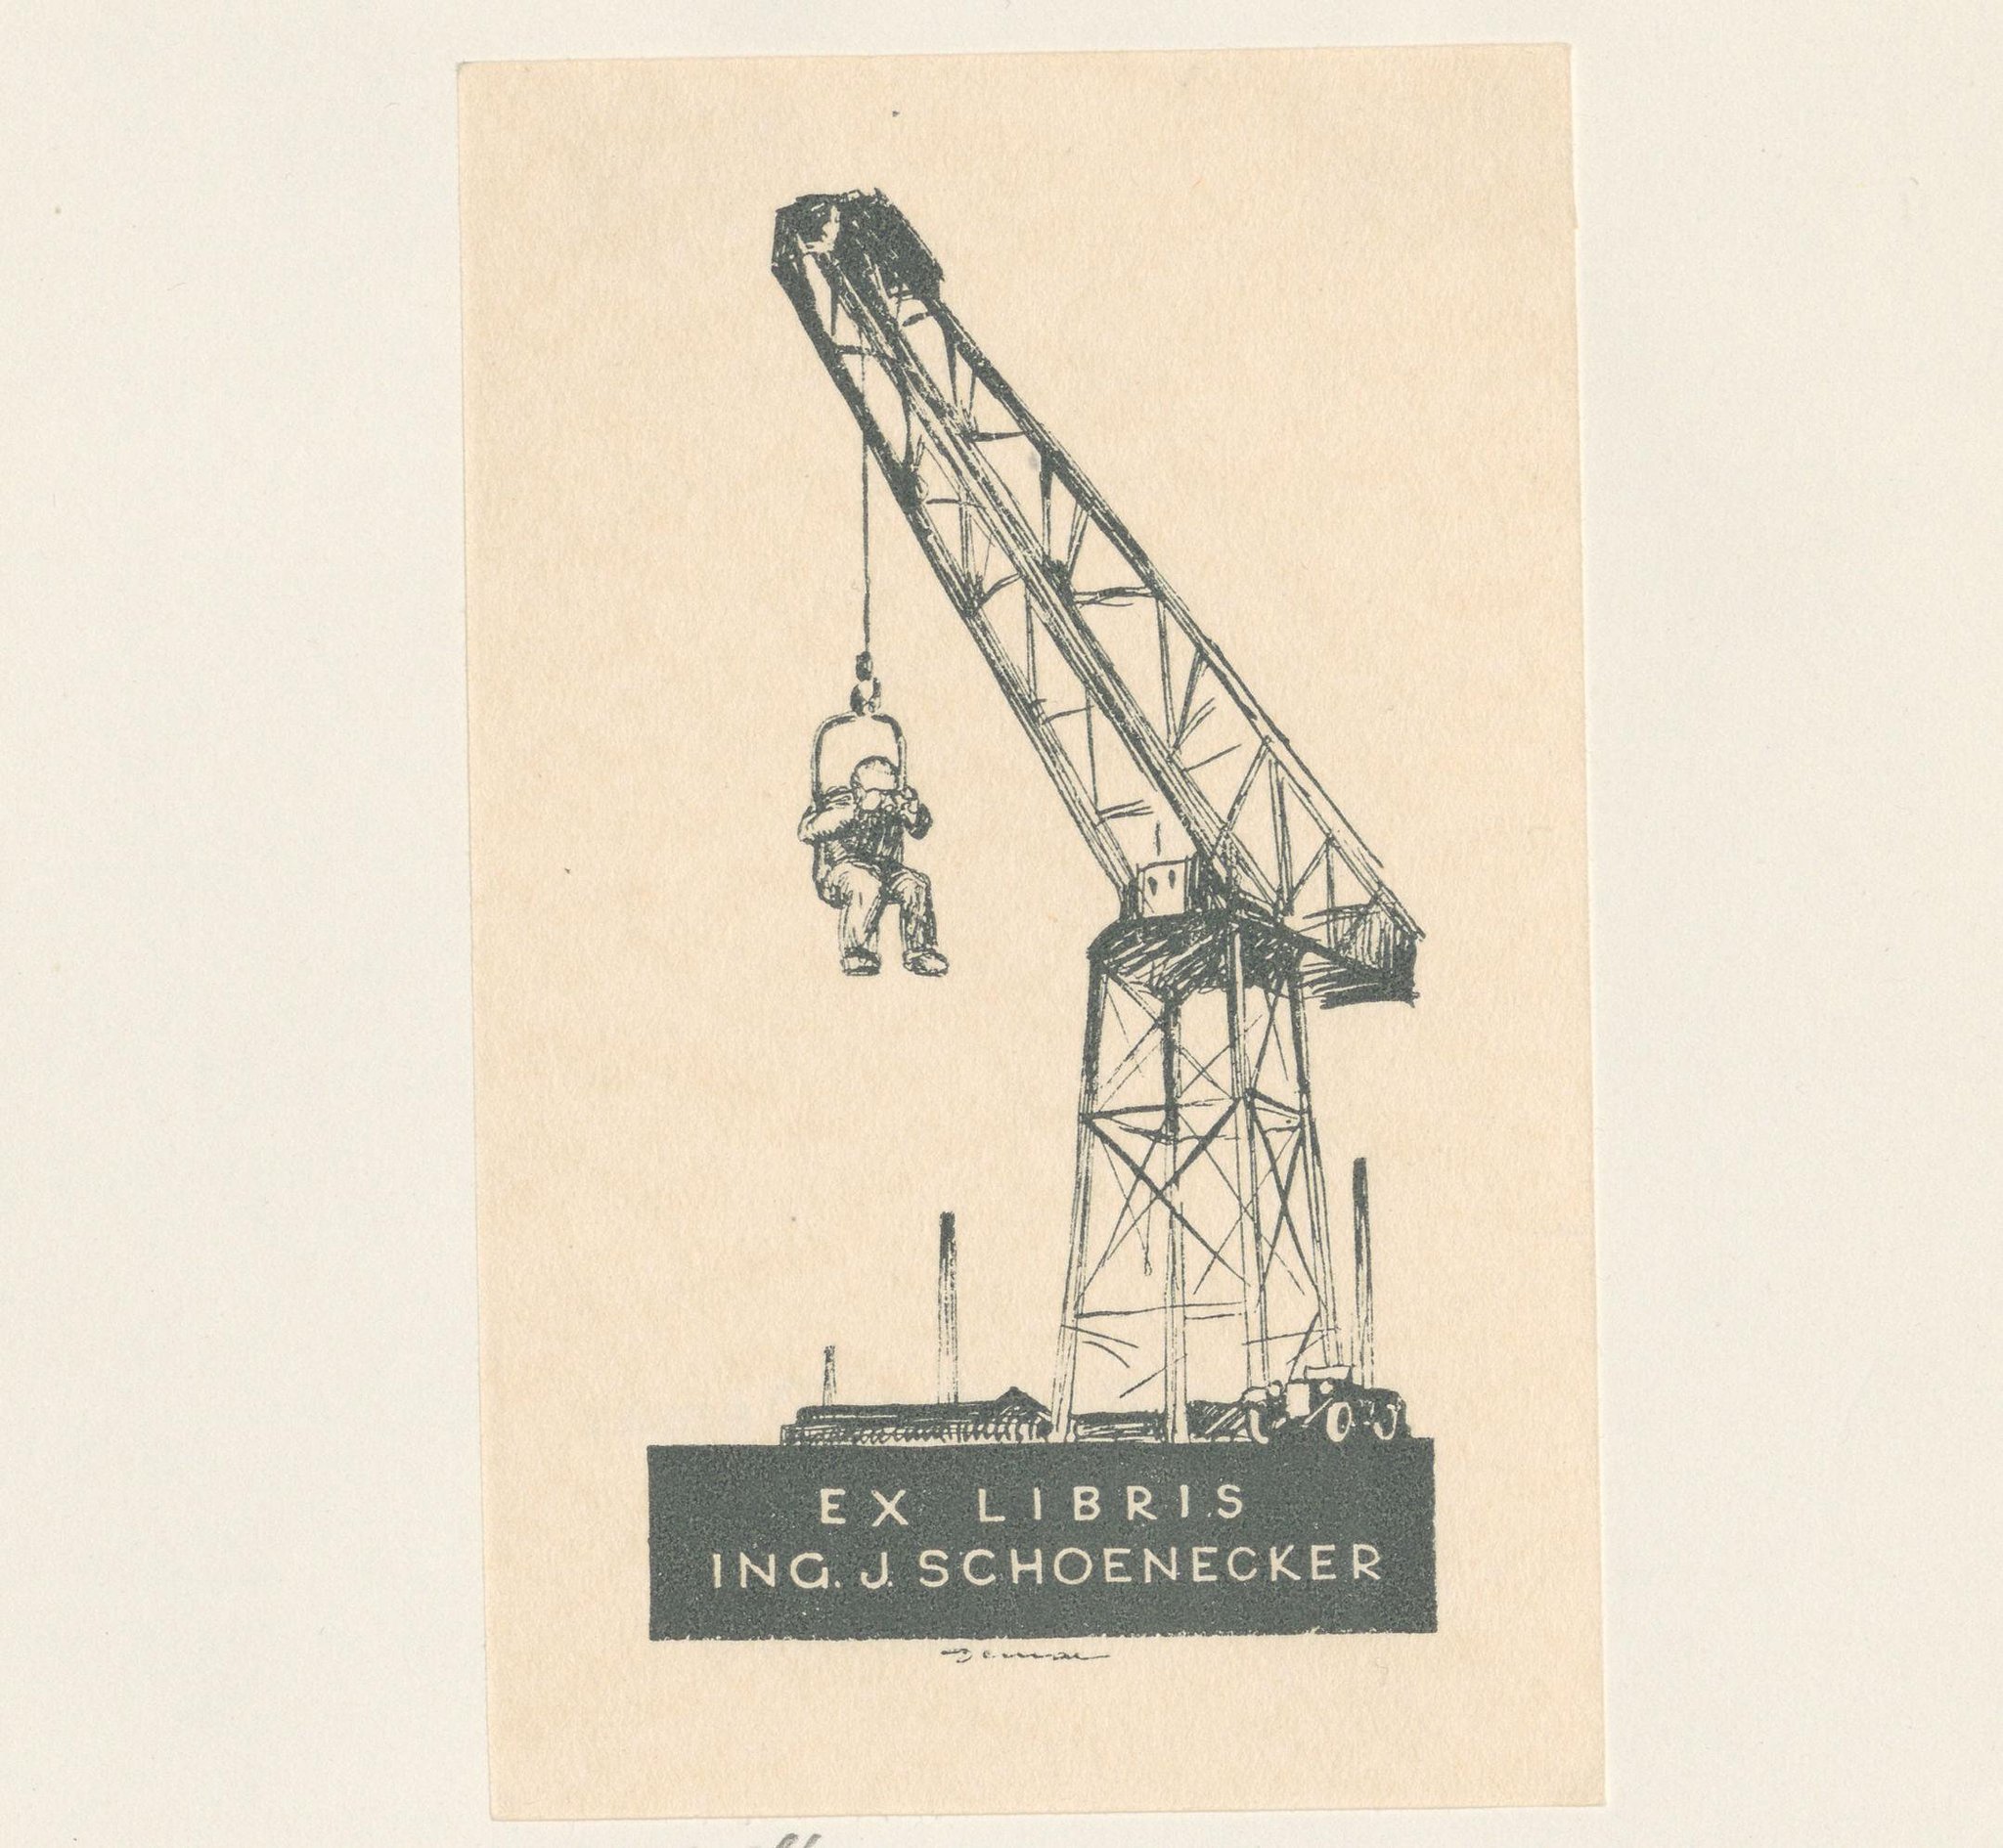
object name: bookplate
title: Ex libris van J. Schoenecker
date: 1930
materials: paper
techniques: printing block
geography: austria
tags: engineer, dock crane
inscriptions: workshop stamp: ‘Ernst v. Demar/ Wien 1930/ Klischee’